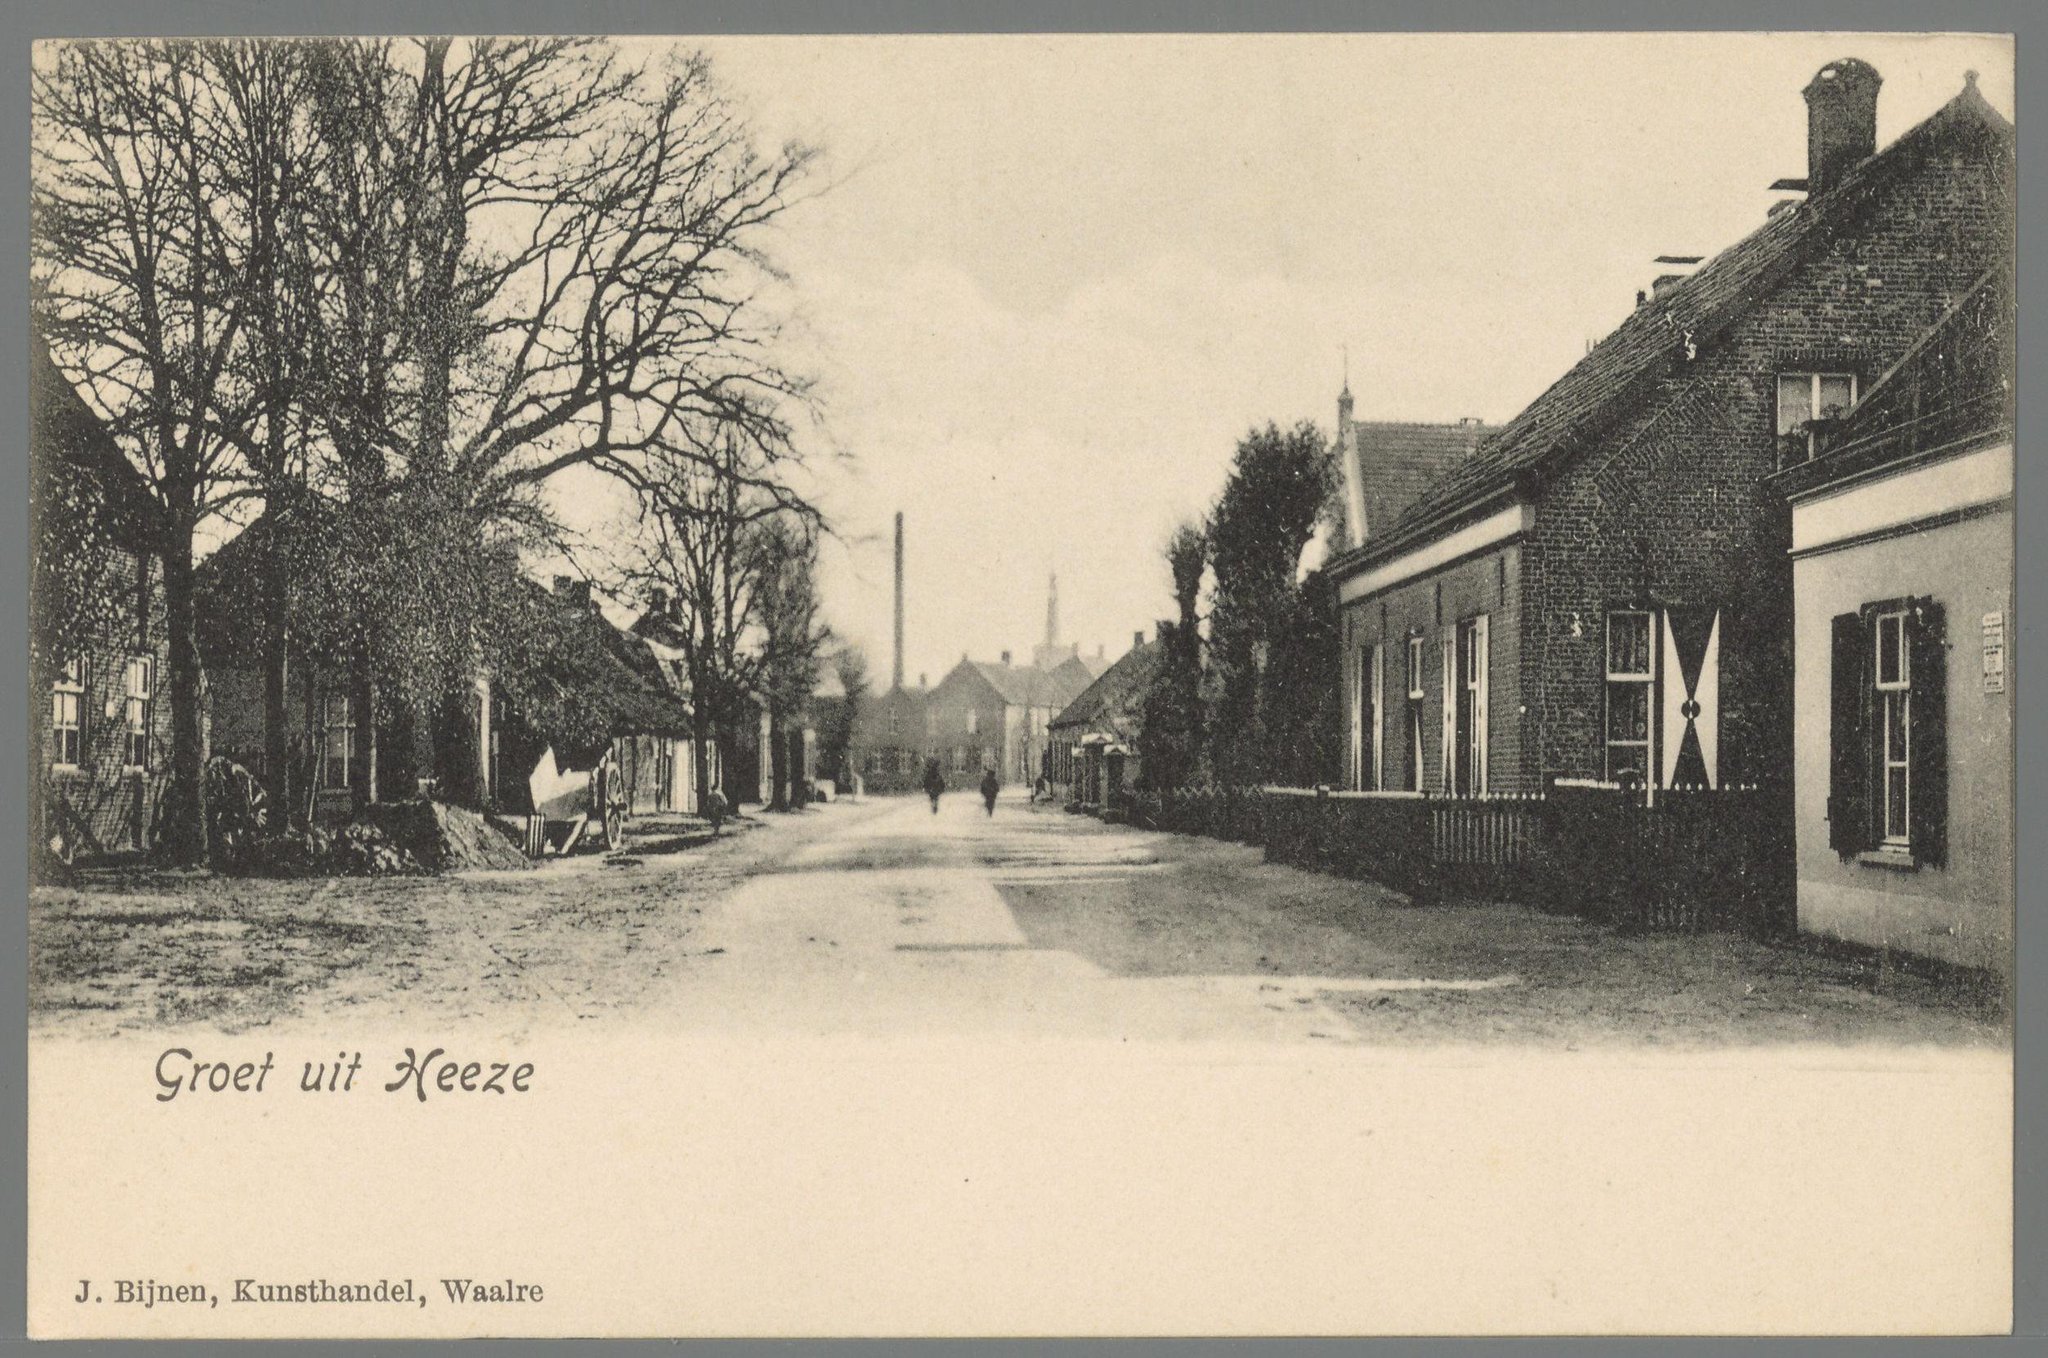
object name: ansichtkaart, prentbriefkaart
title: Groet uit Heeze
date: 1897-1905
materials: cardboard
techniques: photograph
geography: heeze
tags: street